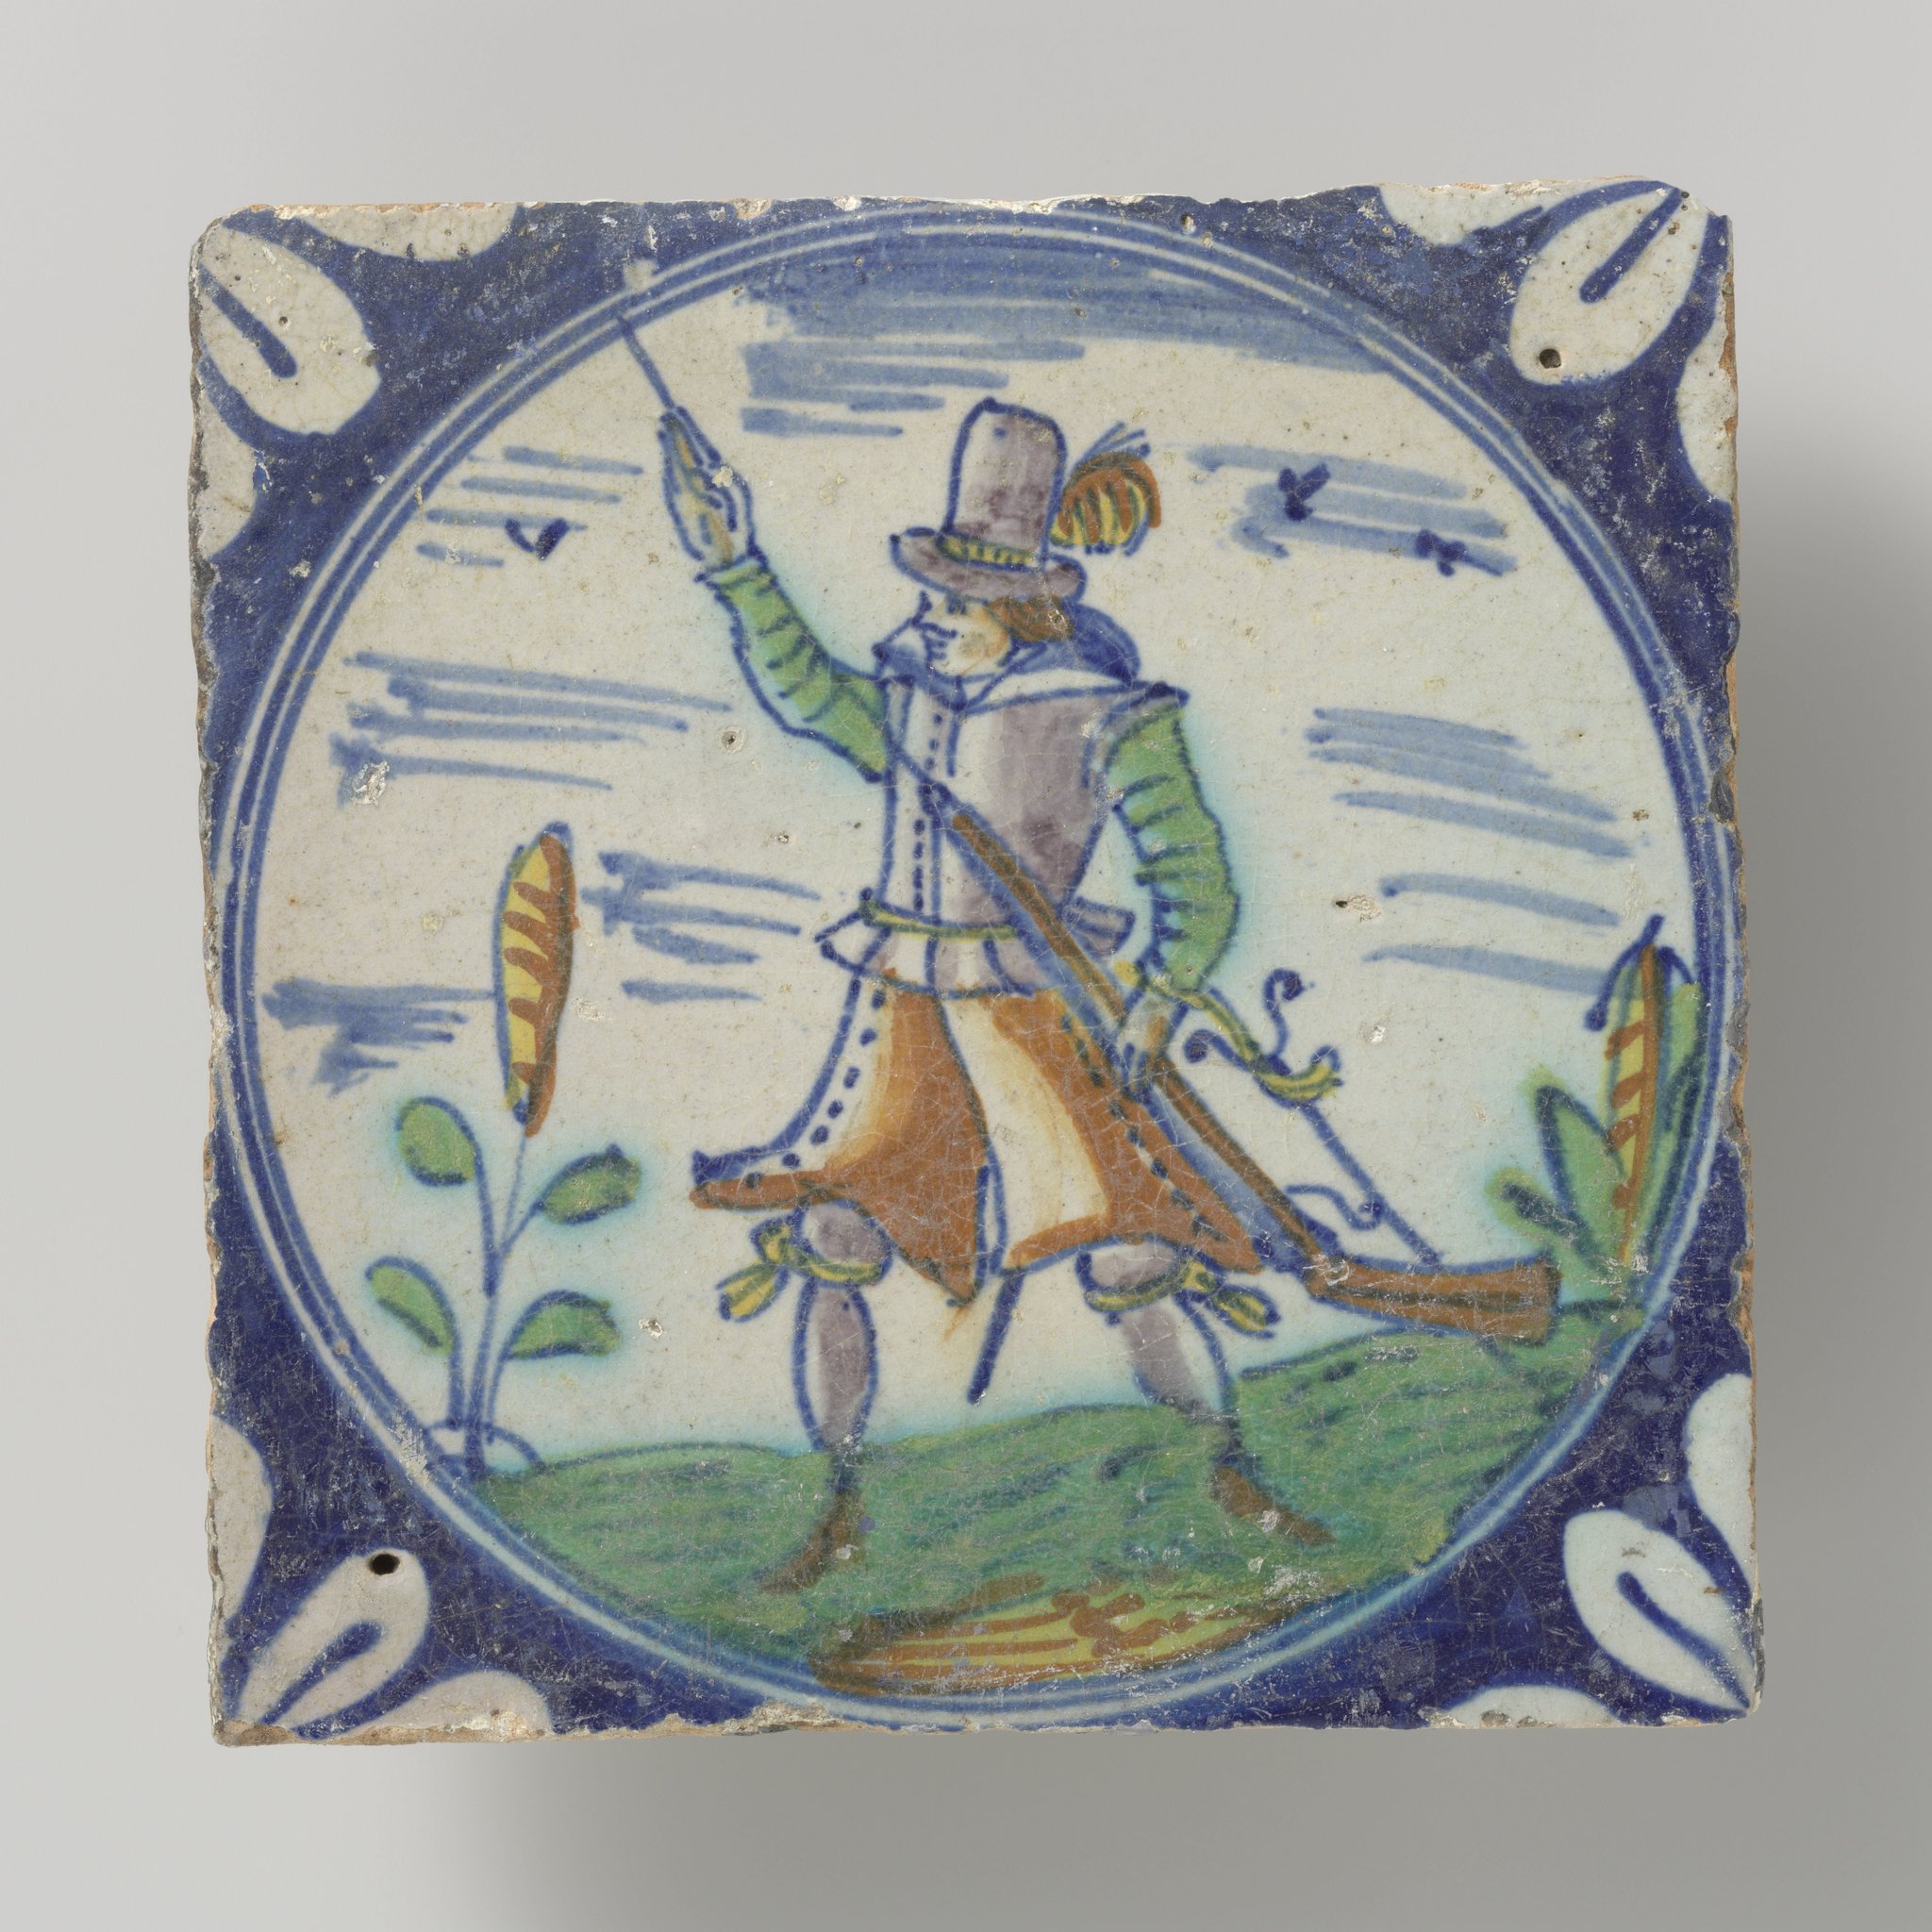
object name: tile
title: Tegel, veelkleurig beschilderd met een soldaat of een vaandeldrager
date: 1625-1700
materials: earthenware, glaze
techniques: maiolica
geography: netherlands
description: Tegel, veelkleurig beschilderd met een soldaat of een vaandeldrager.